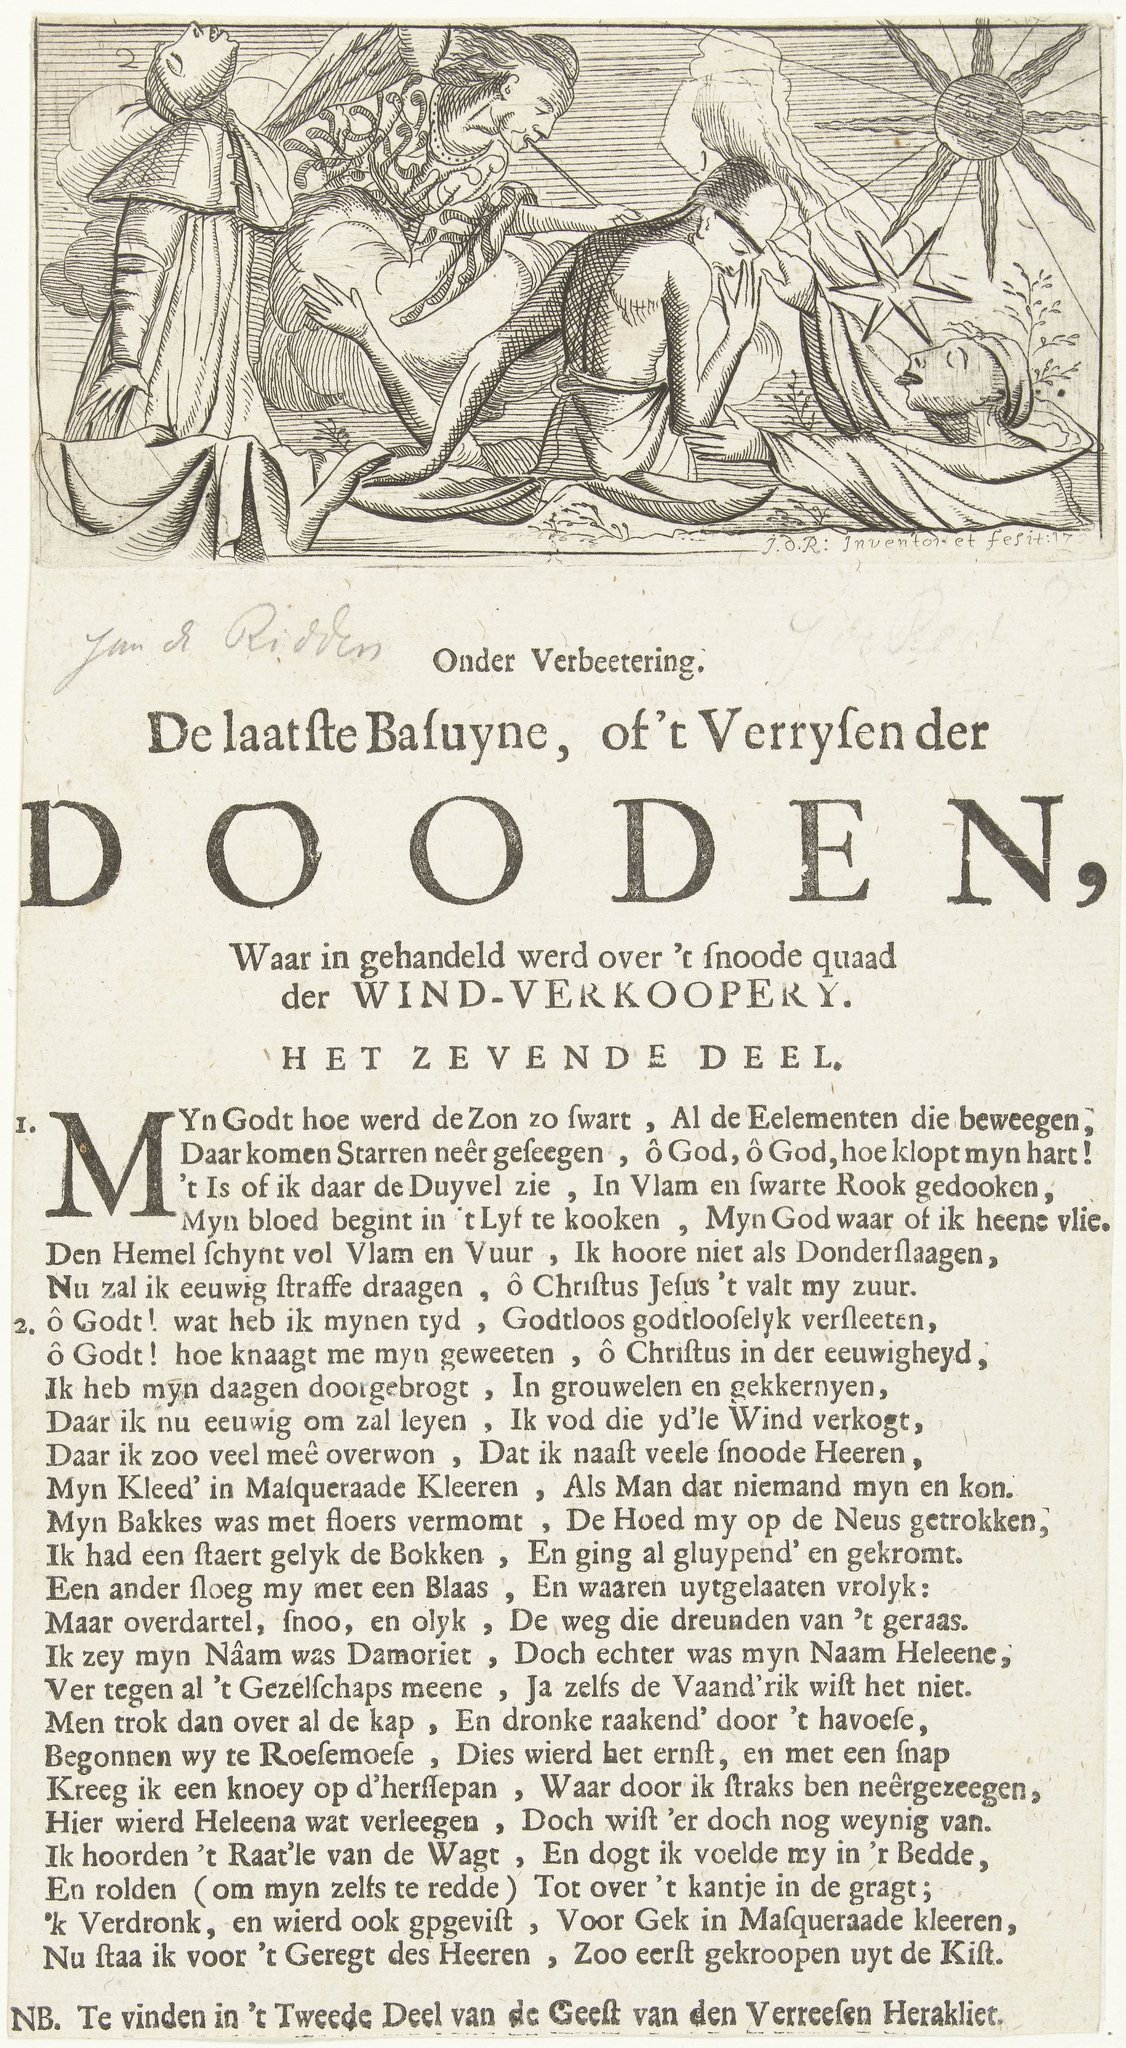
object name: print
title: De laatste bazuin of het verrijzen der doden (dl. 7), 1720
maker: jan de ridder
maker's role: print maker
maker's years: 1665-1735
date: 1720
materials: paper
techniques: etching, letterpress printing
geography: northern netherlands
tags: resurrection of the dead ~ last judgement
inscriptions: collector's mark: Lugt 2228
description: Bij het Laatste Oordeel verrijzen de doden uit hun graven, in de wolken een engel met bazuin, rechts de zwarte huilende zon. Zevende prent in een serie van acht prenten getiteld: De laatste bazuin of het verrijzen der doden, over de gevolgen van de actiehandel geplaatst in een christelijke context. Op het blad onder de plaat een gedrukte tekst met een vers waarin de voorstelling verklaard wordt. Behoort tot de groep van bijprenten toegevoegd aan de serie Tafereel der Dwaasheid met spotprenten op de Windhandel of Actiehandel van 1720.